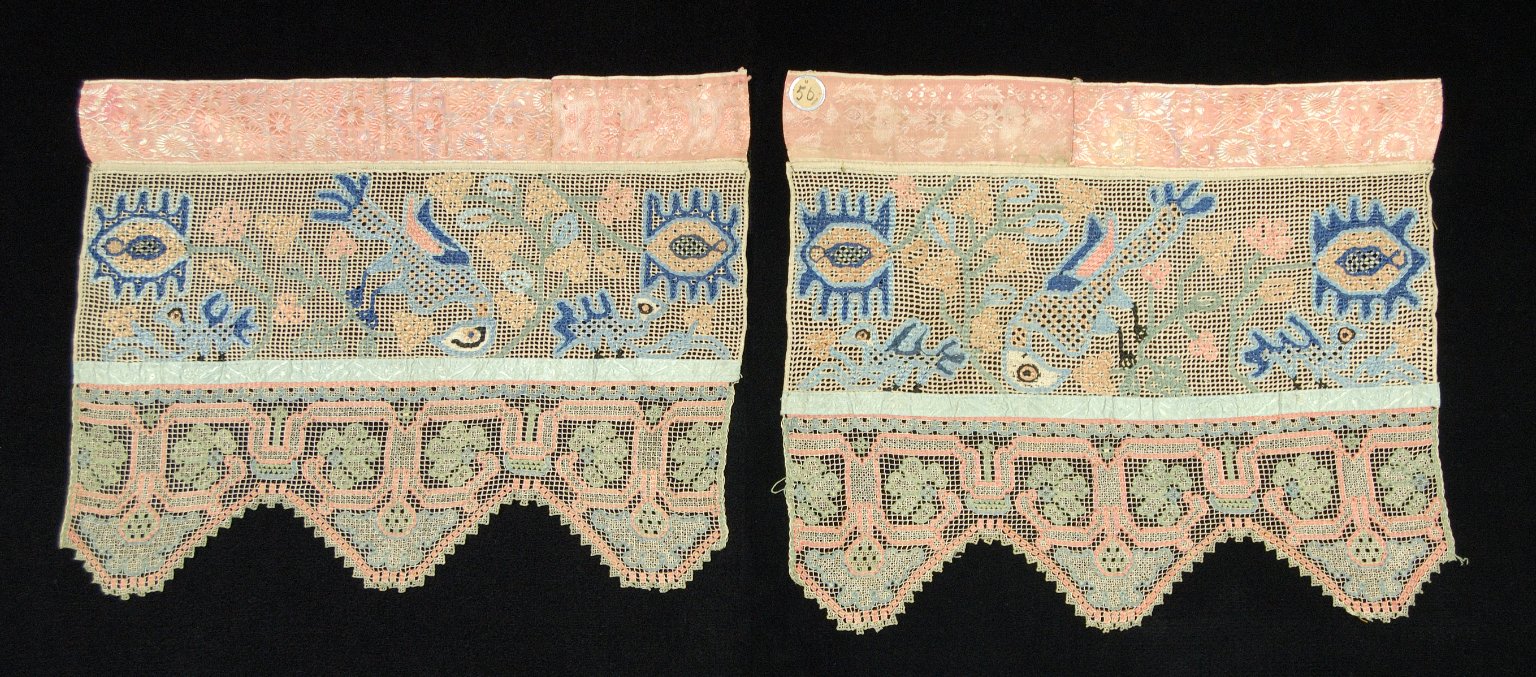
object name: border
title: Towel borders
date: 1800-1850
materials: linen, silk